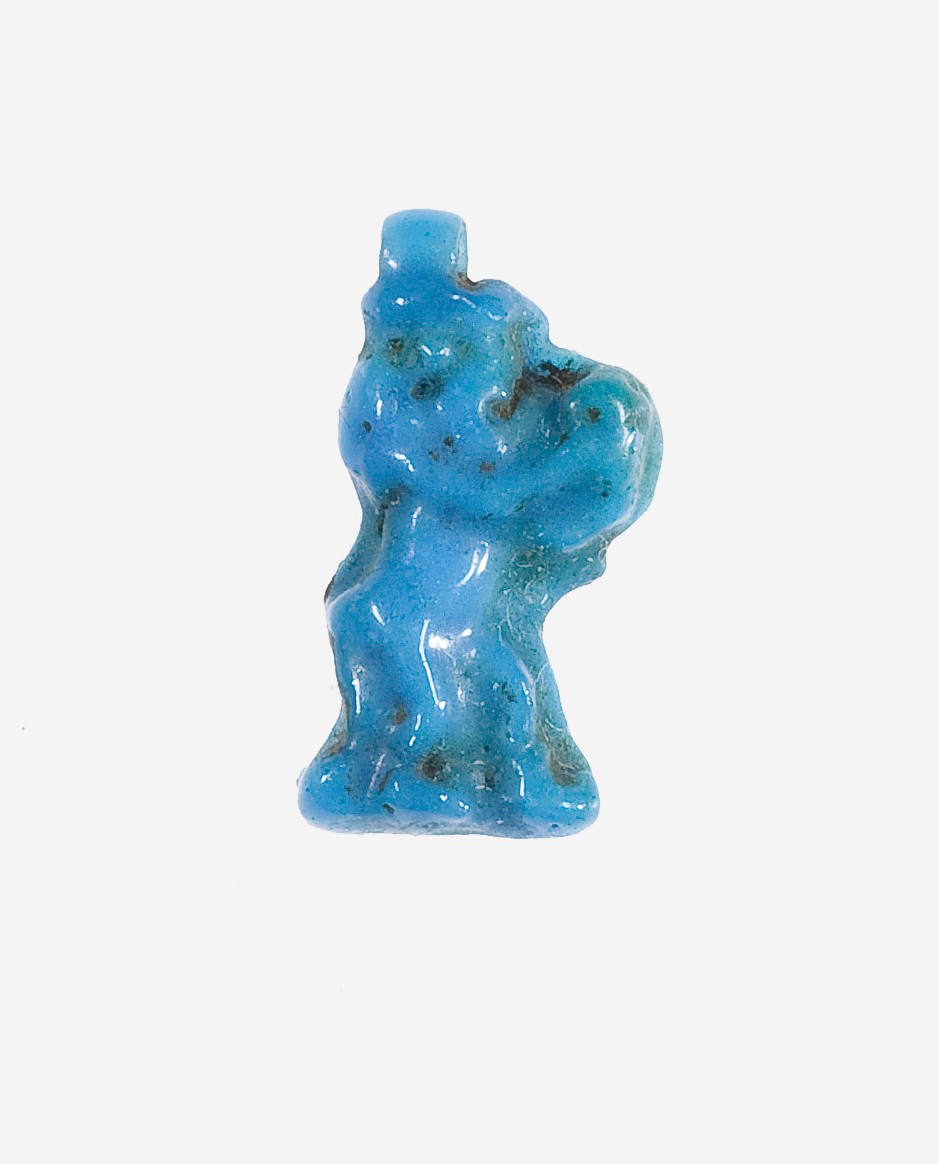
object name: pendant, be, tambourine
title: Amulet of Bes with tambourine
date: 1390-1352 BCE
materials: faience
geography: egypt